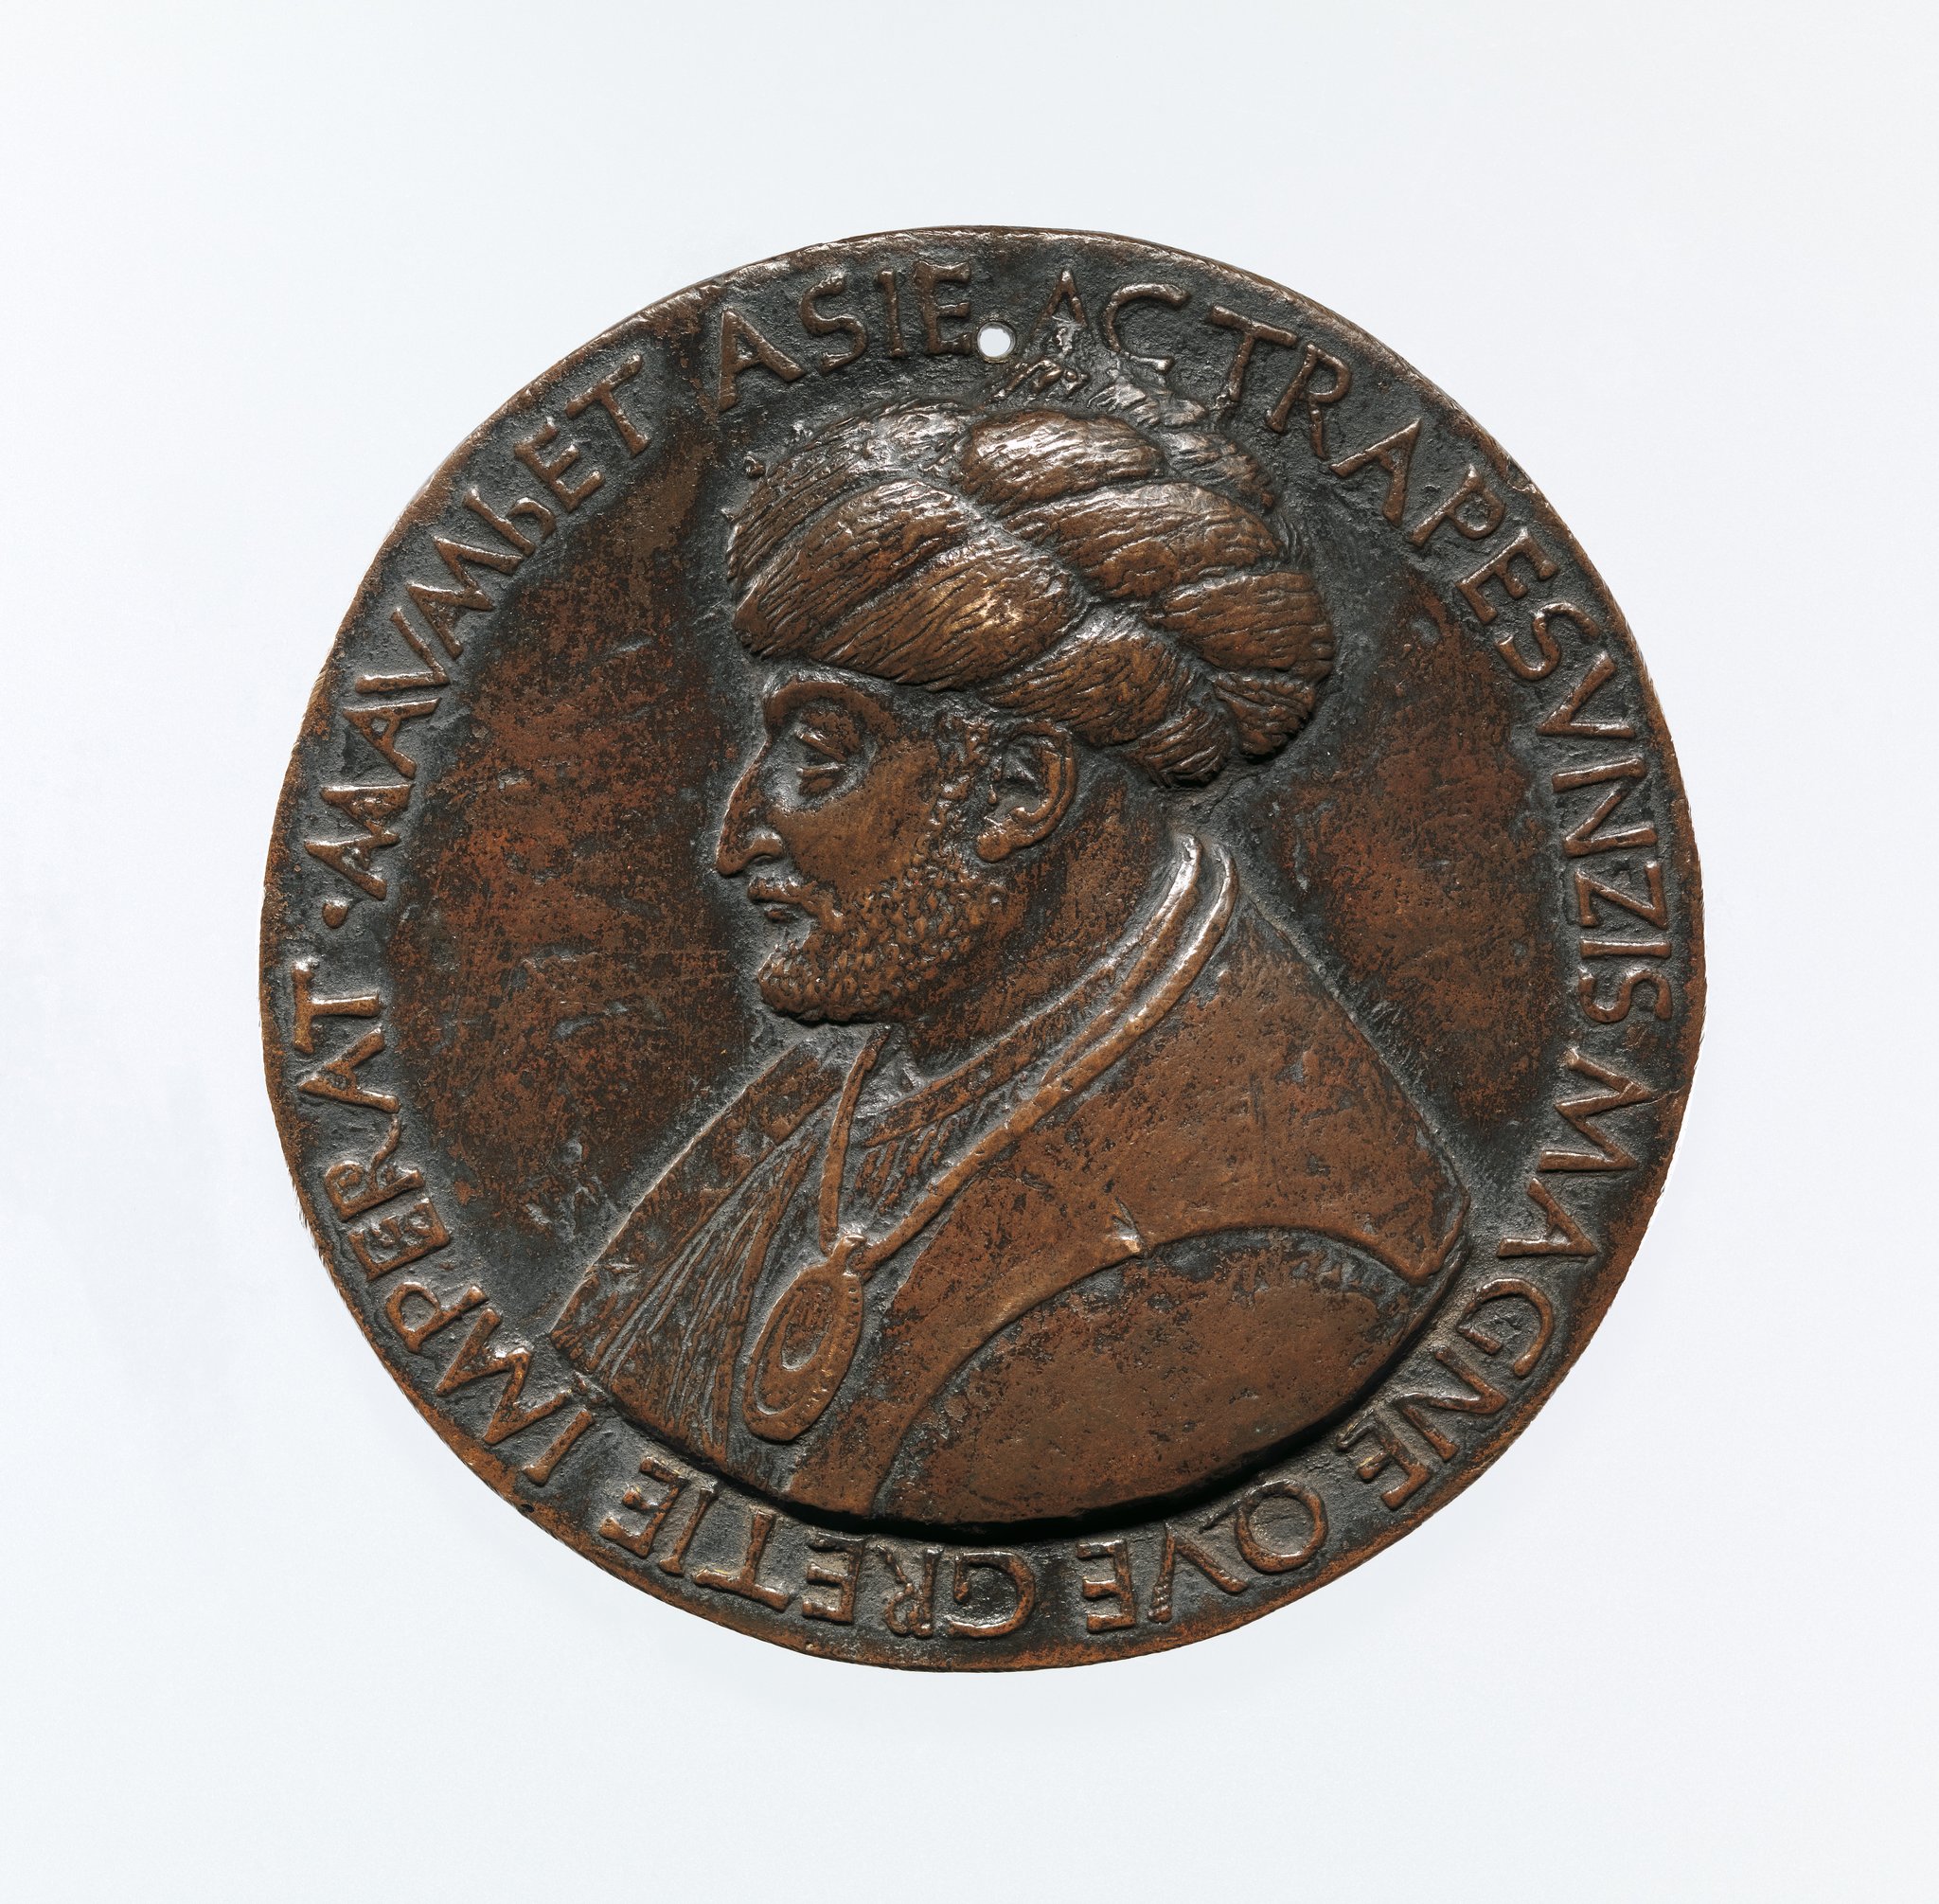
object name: medal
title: Portrait medal of Sultan Mehmed II (obverse); a Triumphal Chariot (reverse)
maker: bertoldo di giovanni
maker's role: artist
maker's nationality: italian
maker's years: 1430-1491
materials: bronze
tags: men,medals,chariots